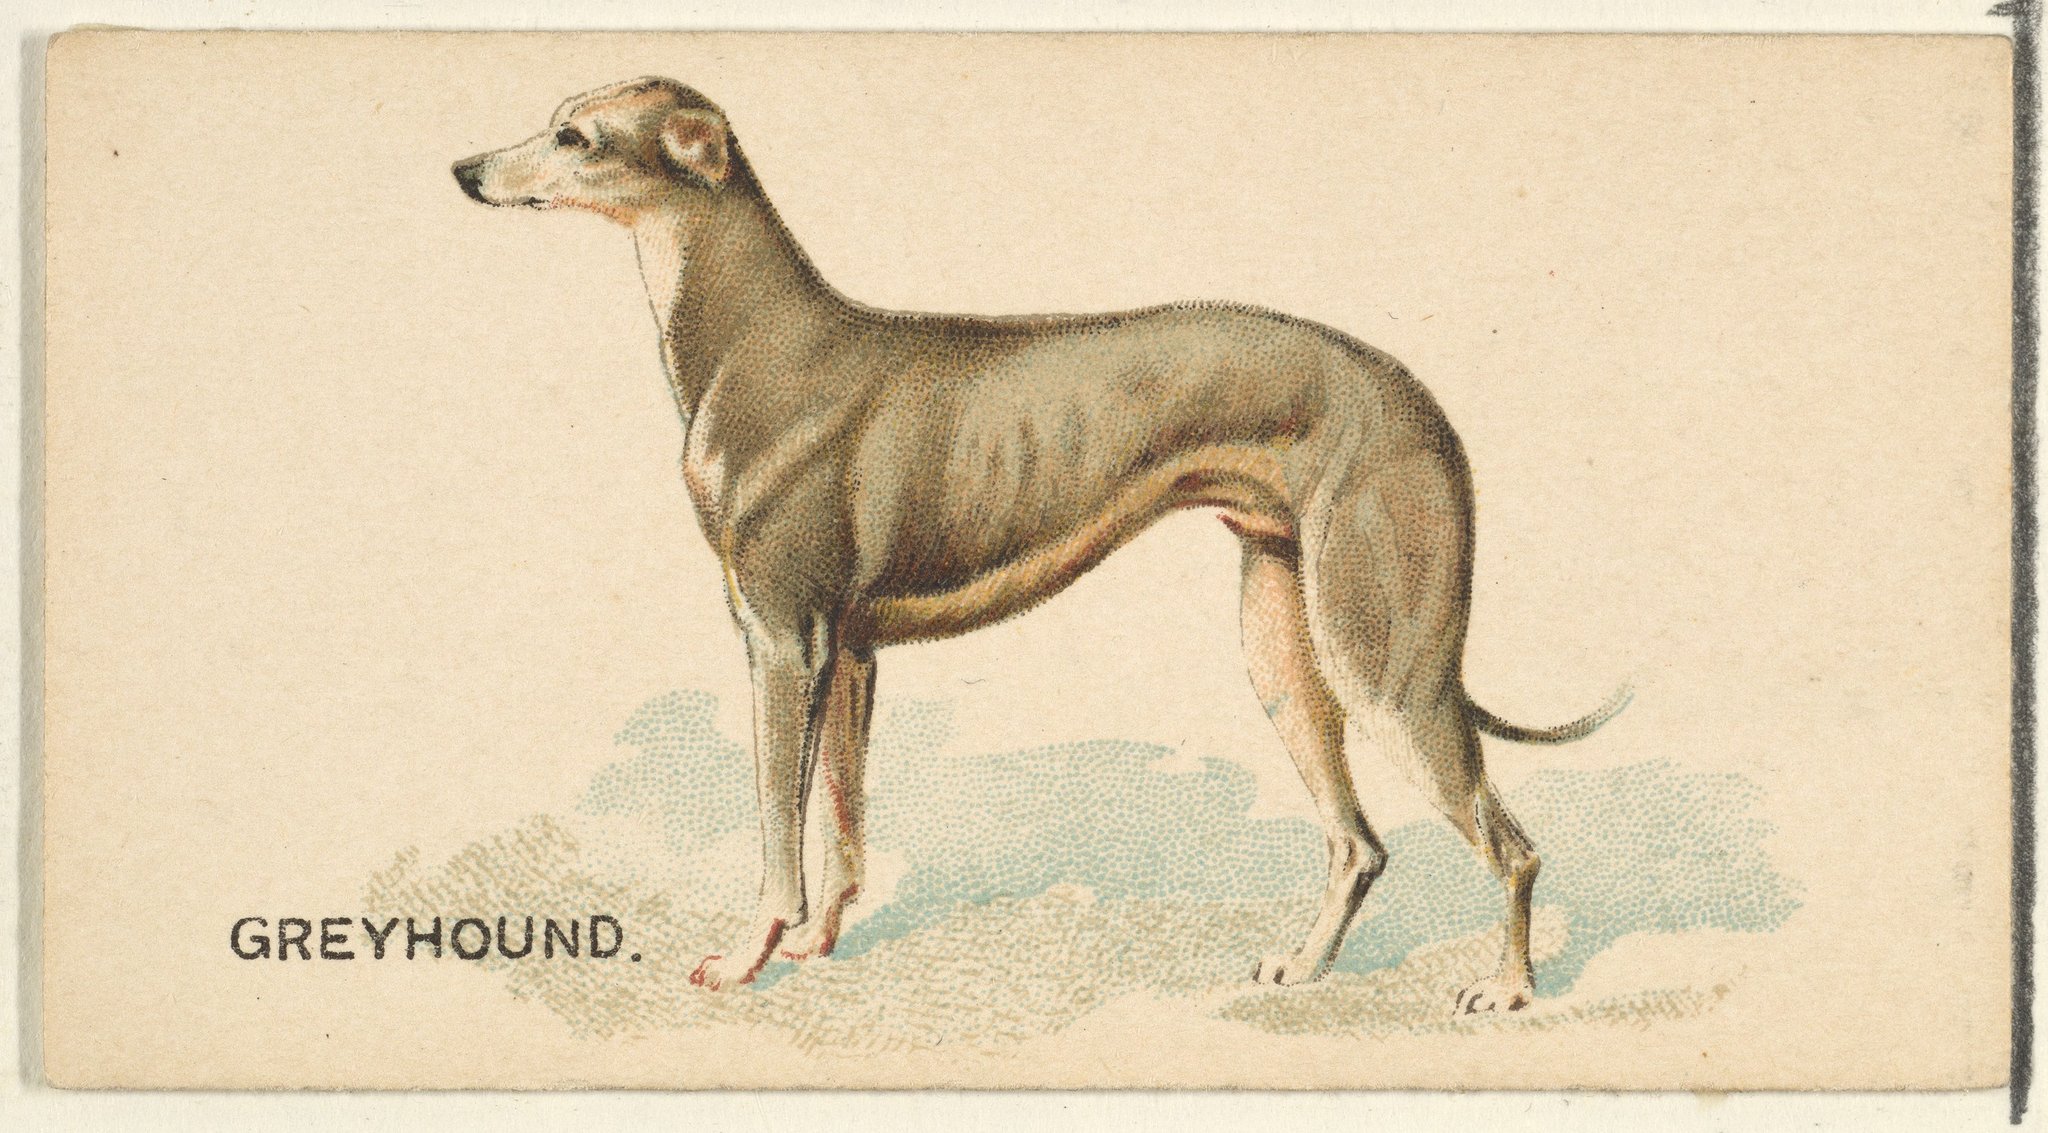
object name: print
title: Greyhound, from the Dogs of the World series for Old Judge Cigarettes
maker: goodwin & company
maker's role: publisher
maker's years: 1850-1950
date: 1890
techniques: color lithograph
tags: dogs